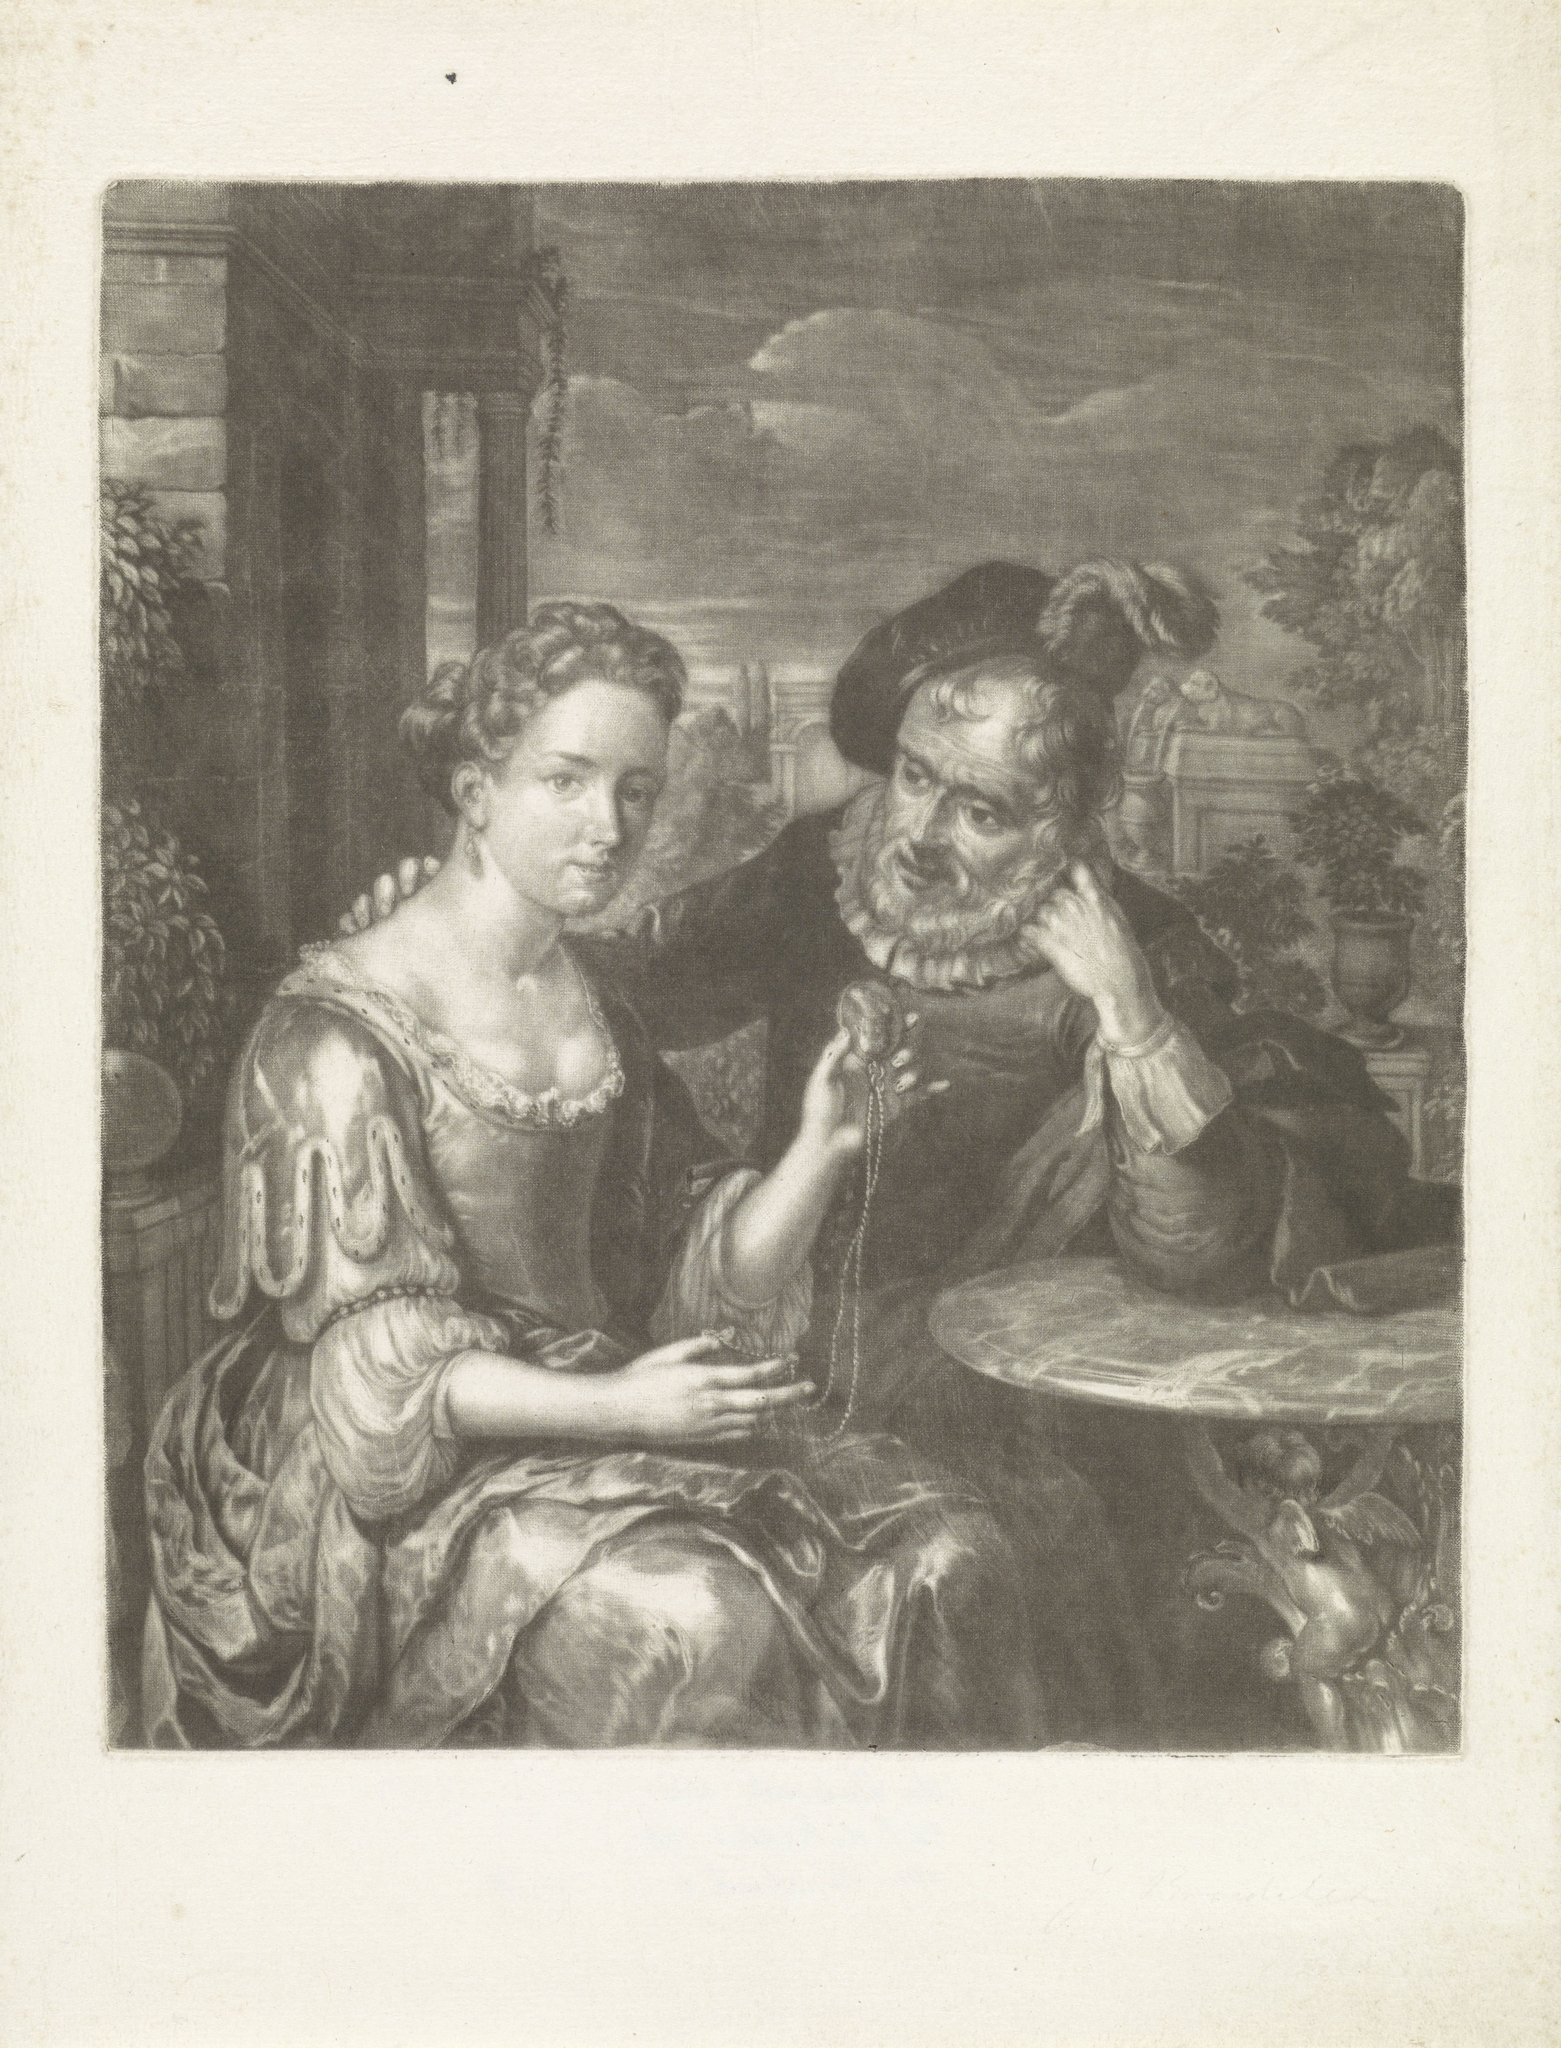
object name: print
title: Jonge vrouw en oude man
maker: jan broedelet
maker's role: print maker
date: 1670-1700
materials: paper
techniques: mezzotint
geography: netherlands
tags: garden, married couple of unequal age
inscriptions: collector's mark: Lugt 2760, collector's mark: Lugt 2228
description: In een tuin zitten een oude man en een jonge vrouw. Zij heeft een medaillon in de hand en hij heeft zijn hand op haar schouder gelegd.